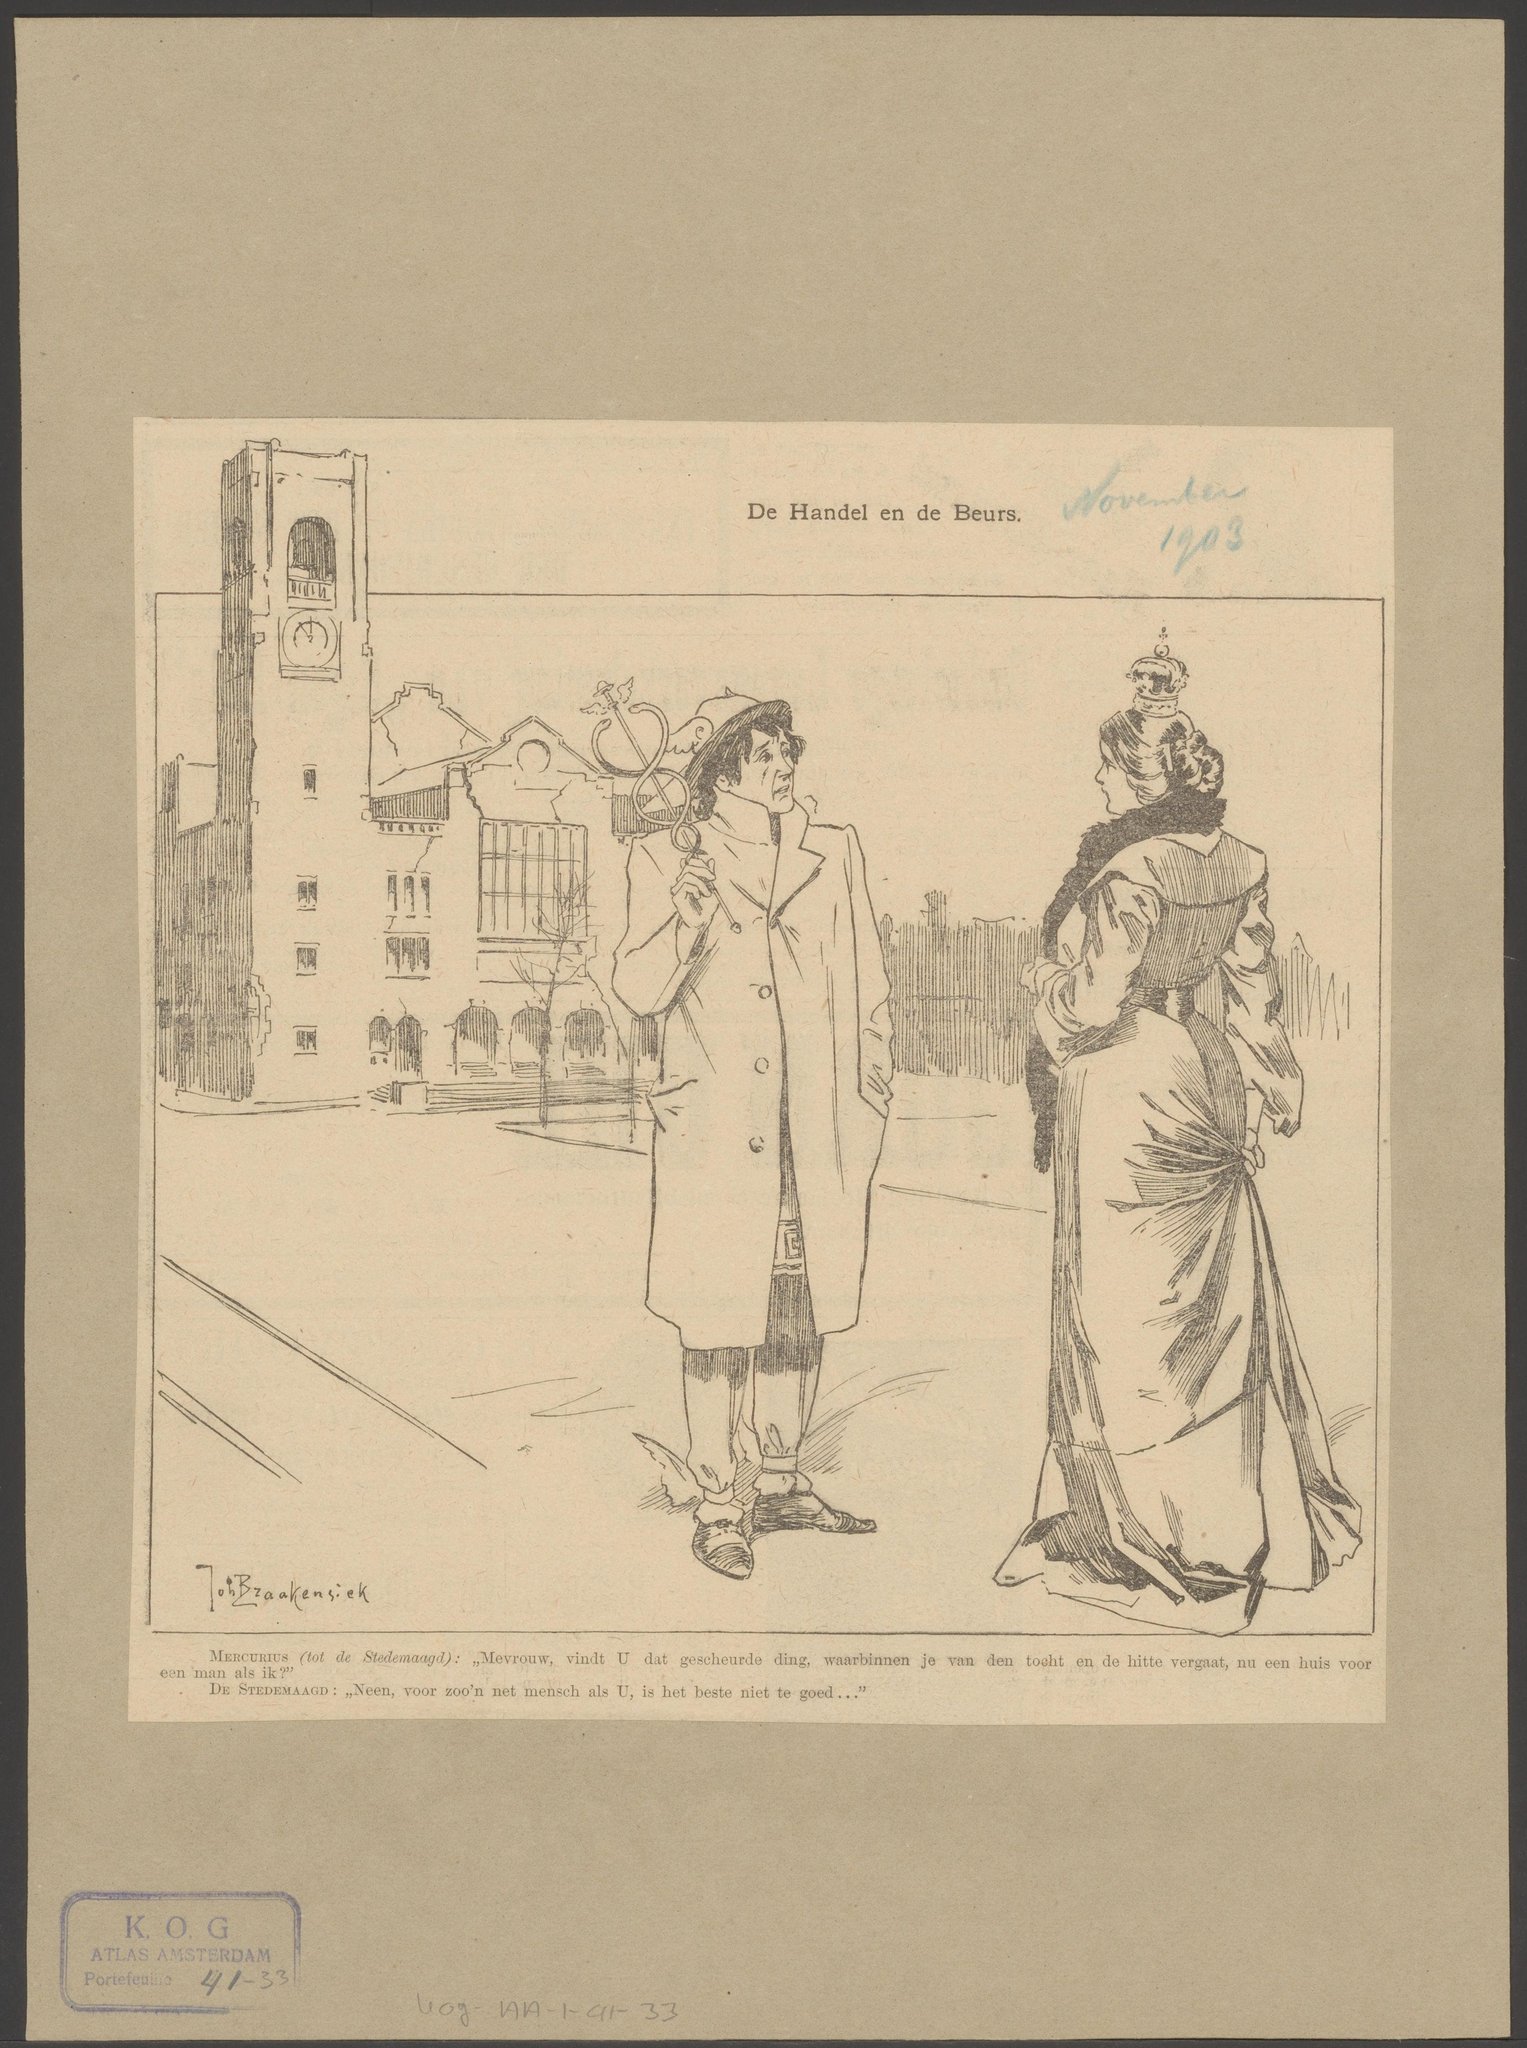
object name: photomechanical print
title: De Handel en de Beurs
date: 1903-1911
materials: paper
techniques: letterpress printing, line block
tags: p.f. laarman, stock exchange, stock-market, allegory of trade; 'commertio della vita humana' (ripa), specific aspects, allegorical aspects of mercury; mercury as patron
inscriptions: collector's mark: Lugt 1461b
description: Onderwerpsrubriek binnen de Atlas Amsterdam: B. Beurs op het Damrak.